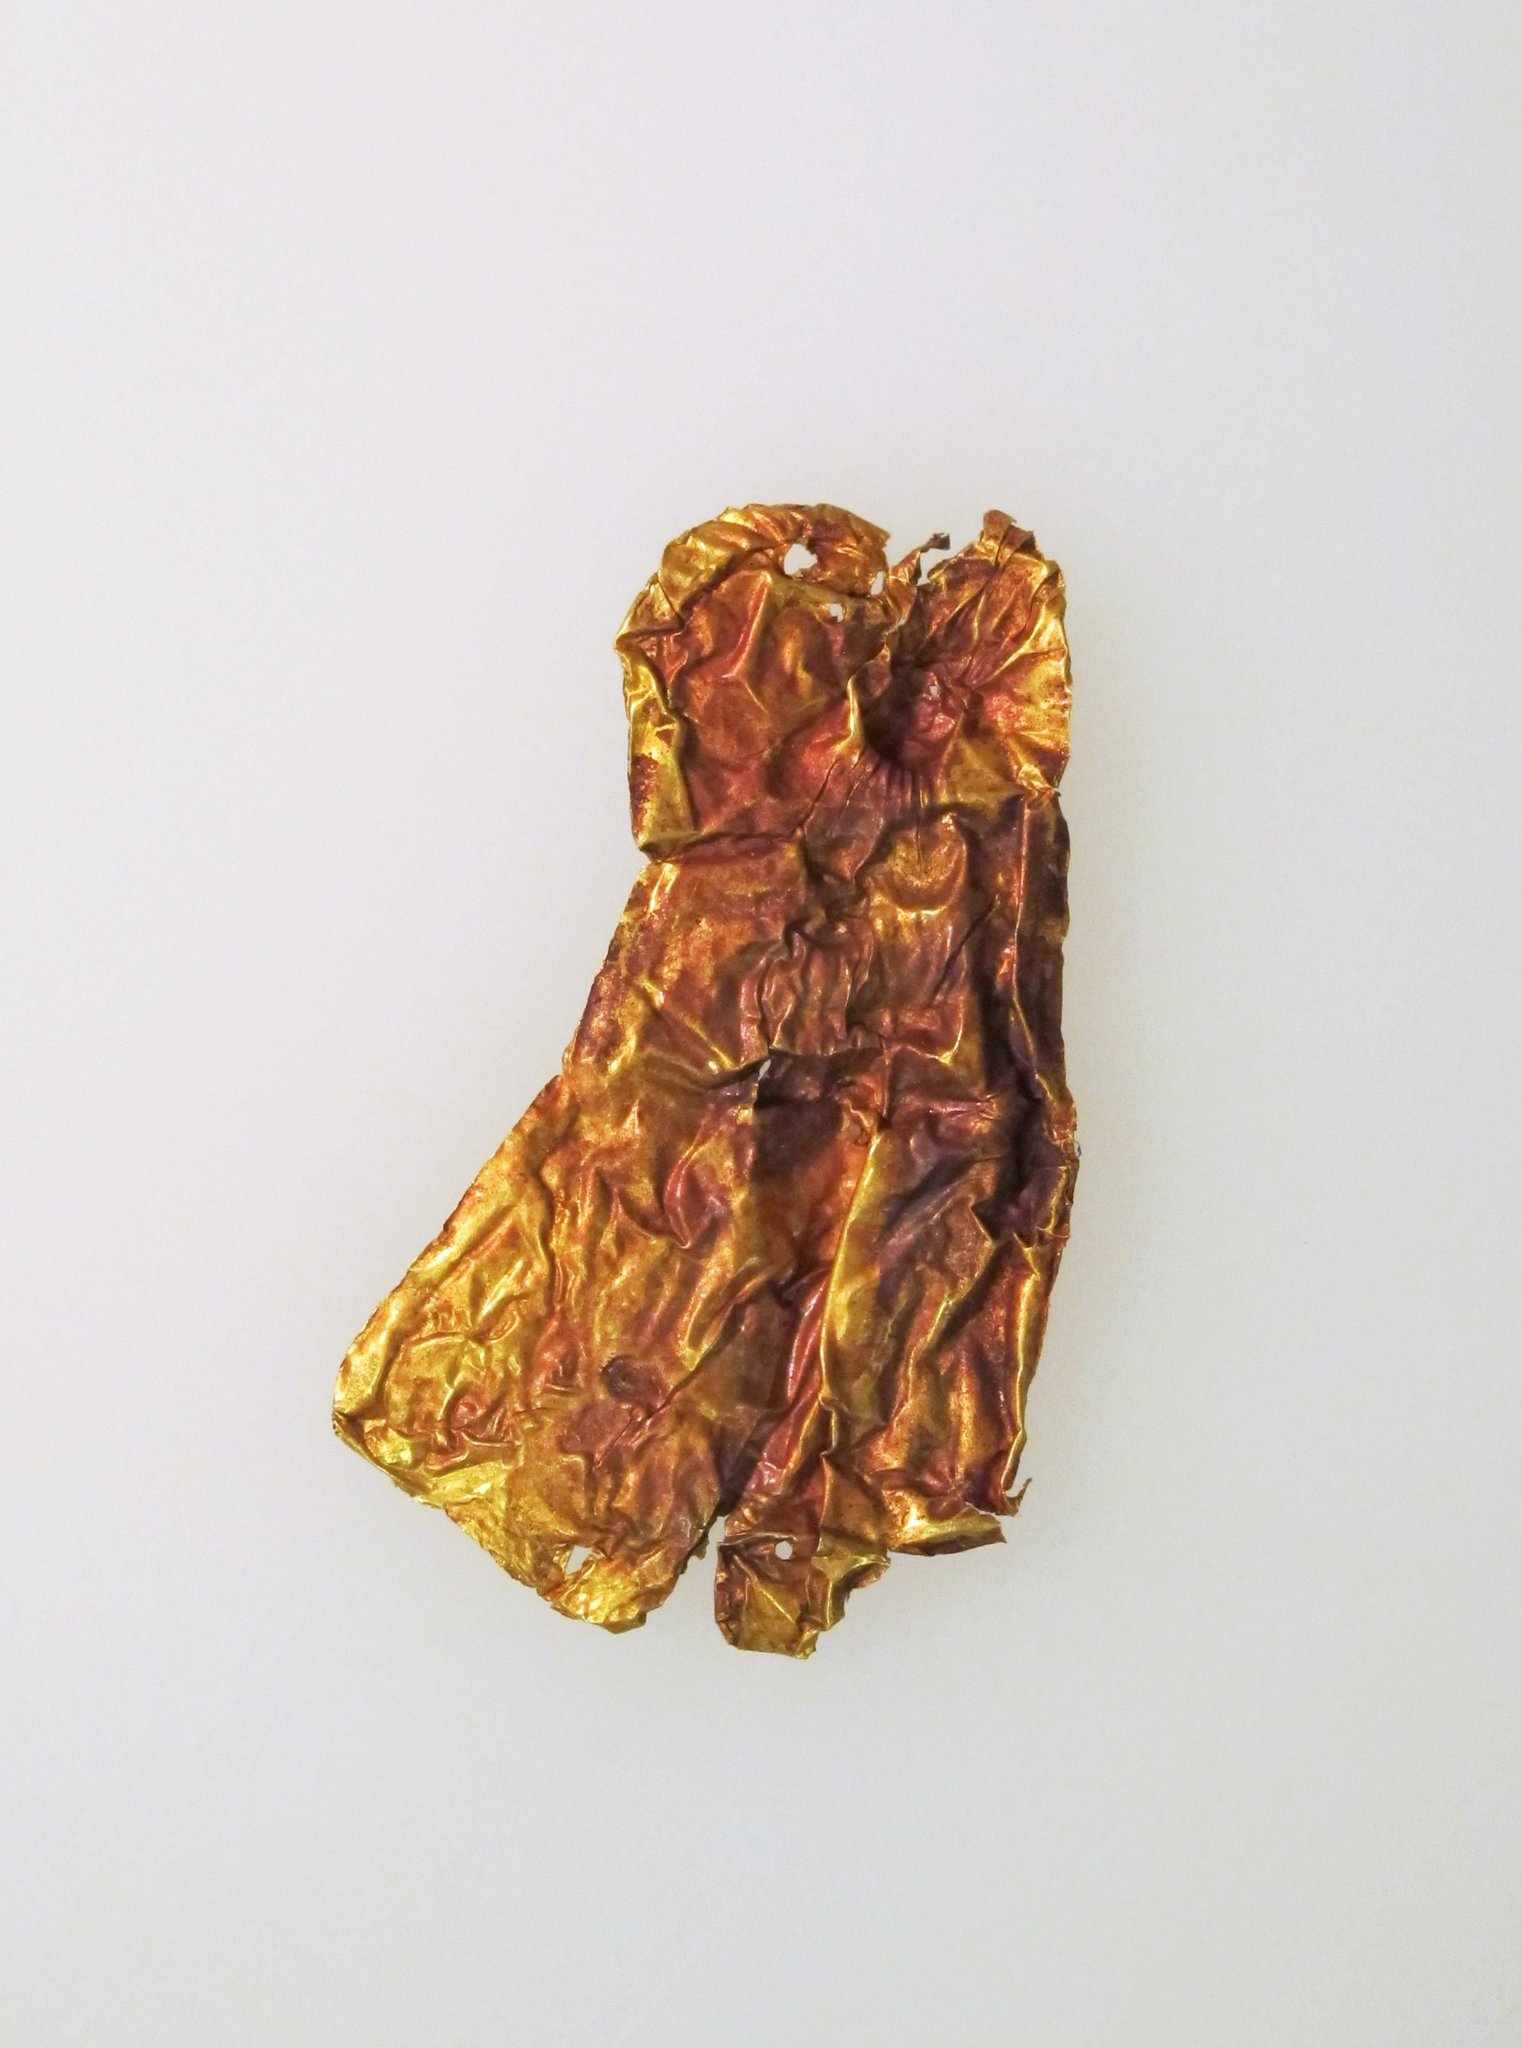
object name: plaque with female figure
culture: etruscan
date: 900-100 BCE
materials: gold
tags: women